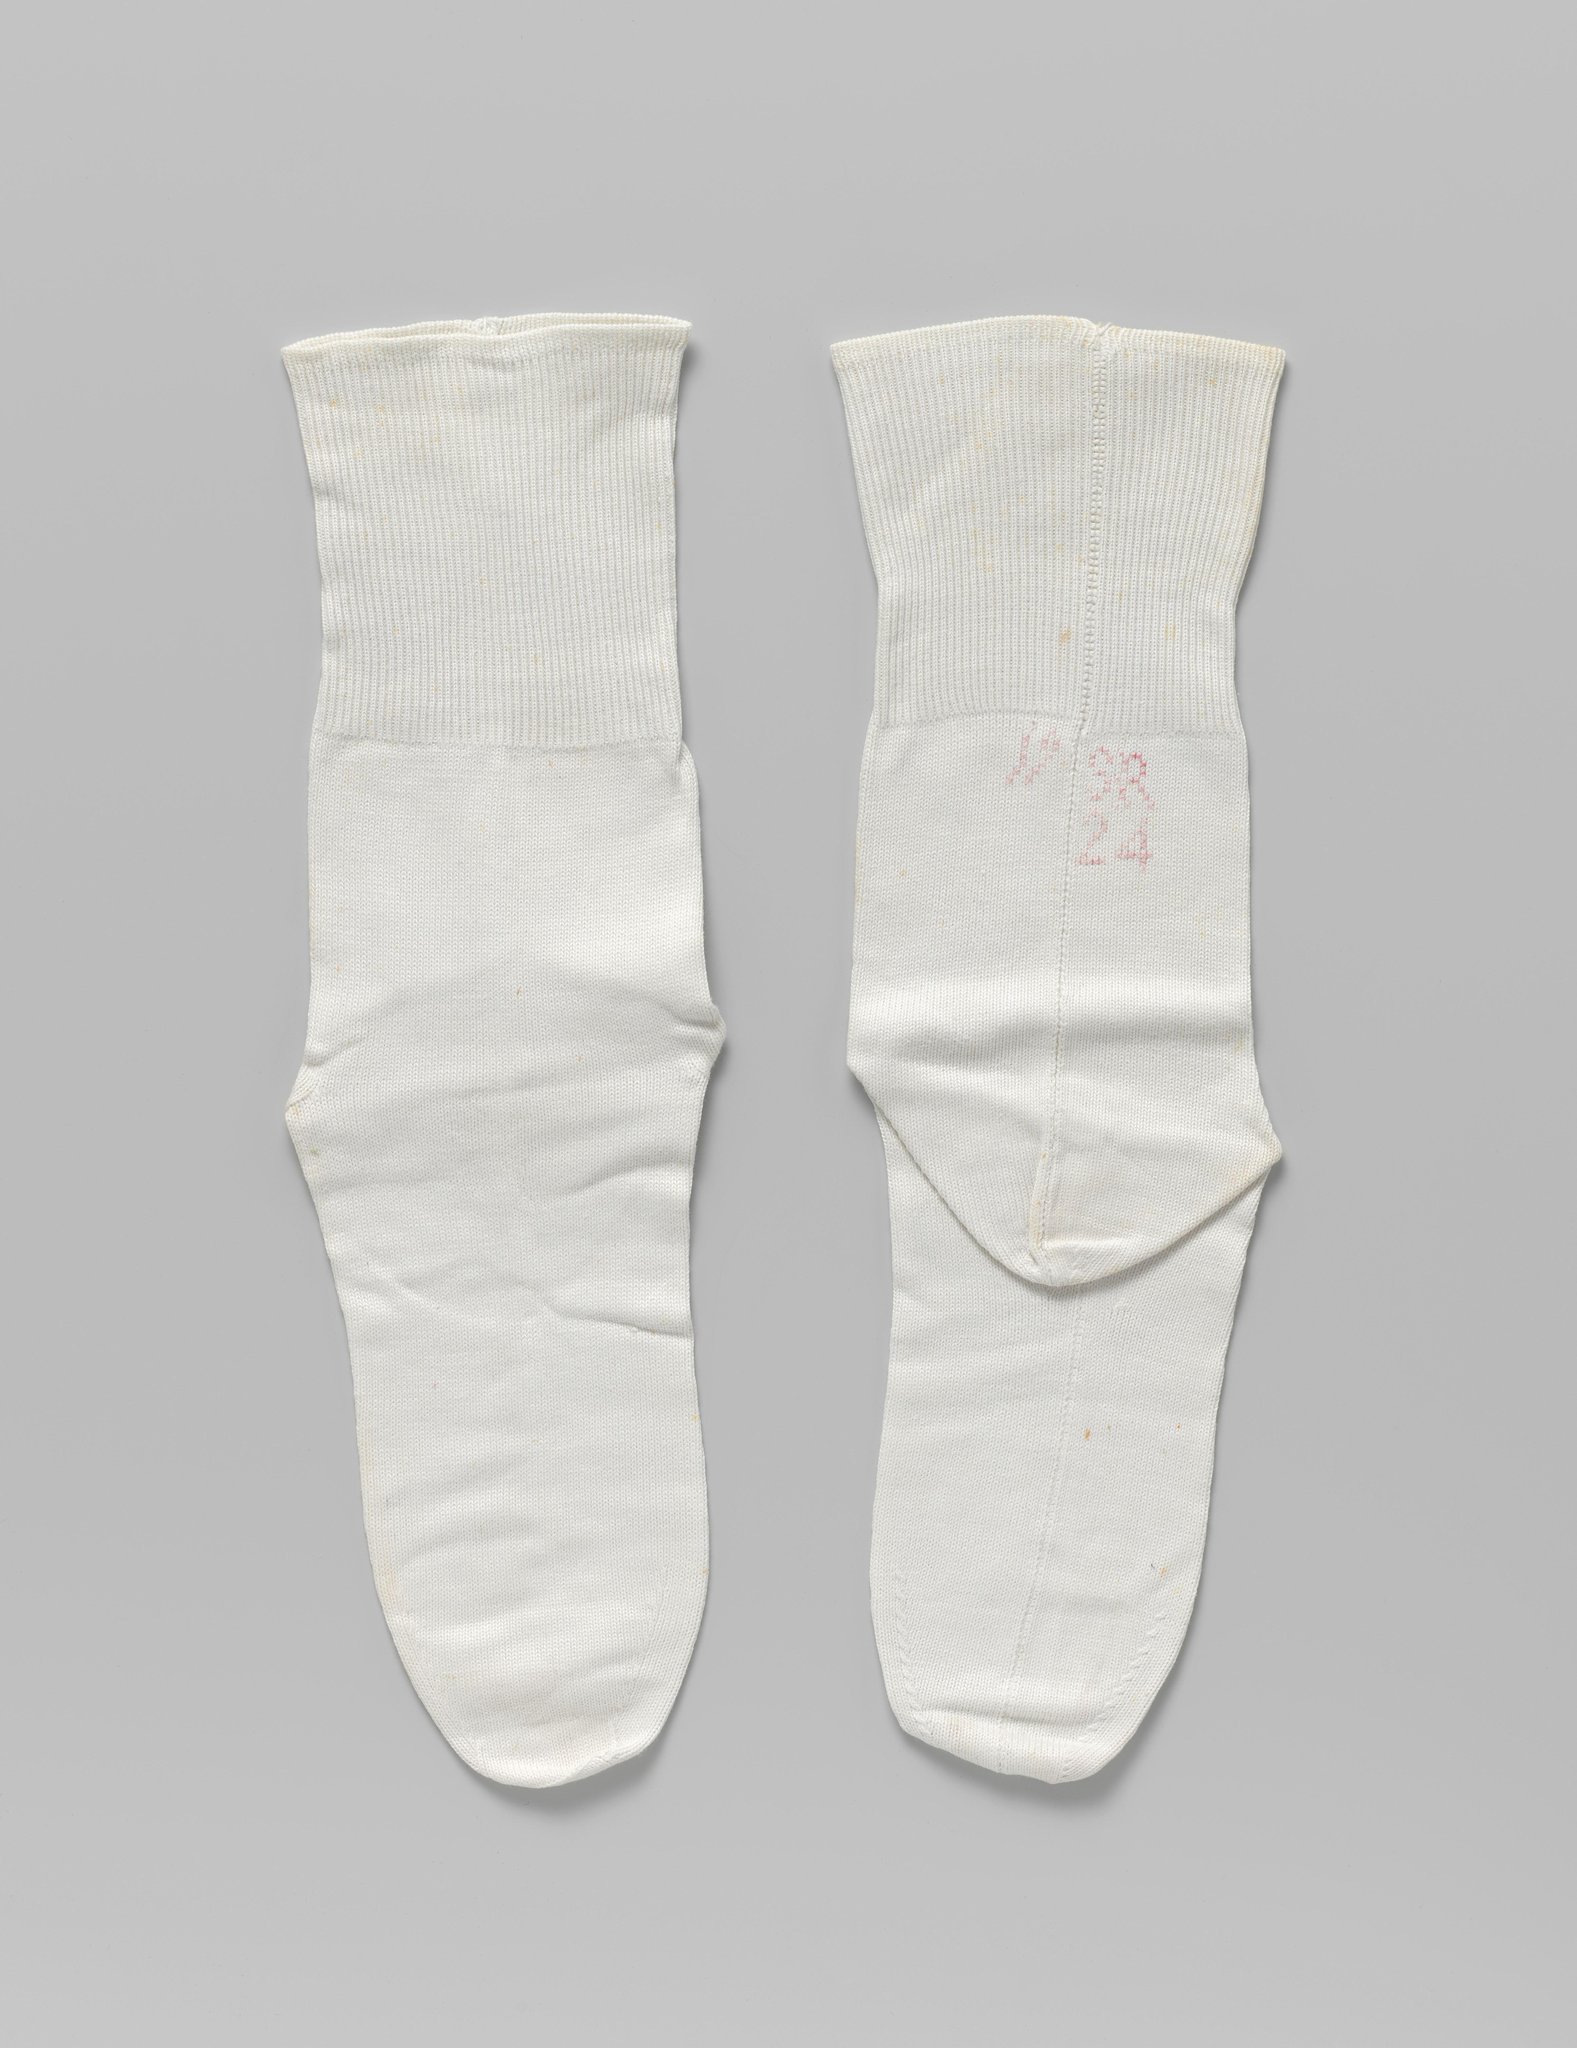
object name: sock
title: Sok of kous van wit katoenen breiwerk; in rode kruissteek gemerkt: 19/SR/24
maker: Anonymous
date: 1900-1919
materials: cotton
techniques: cross stitching, knitting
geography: netherlands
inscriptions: initials: ‘19 SR / 24’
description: Sok of kous van wit katoenen breiwerk; in rode kruissteek gemerkt: 19/SR/24.